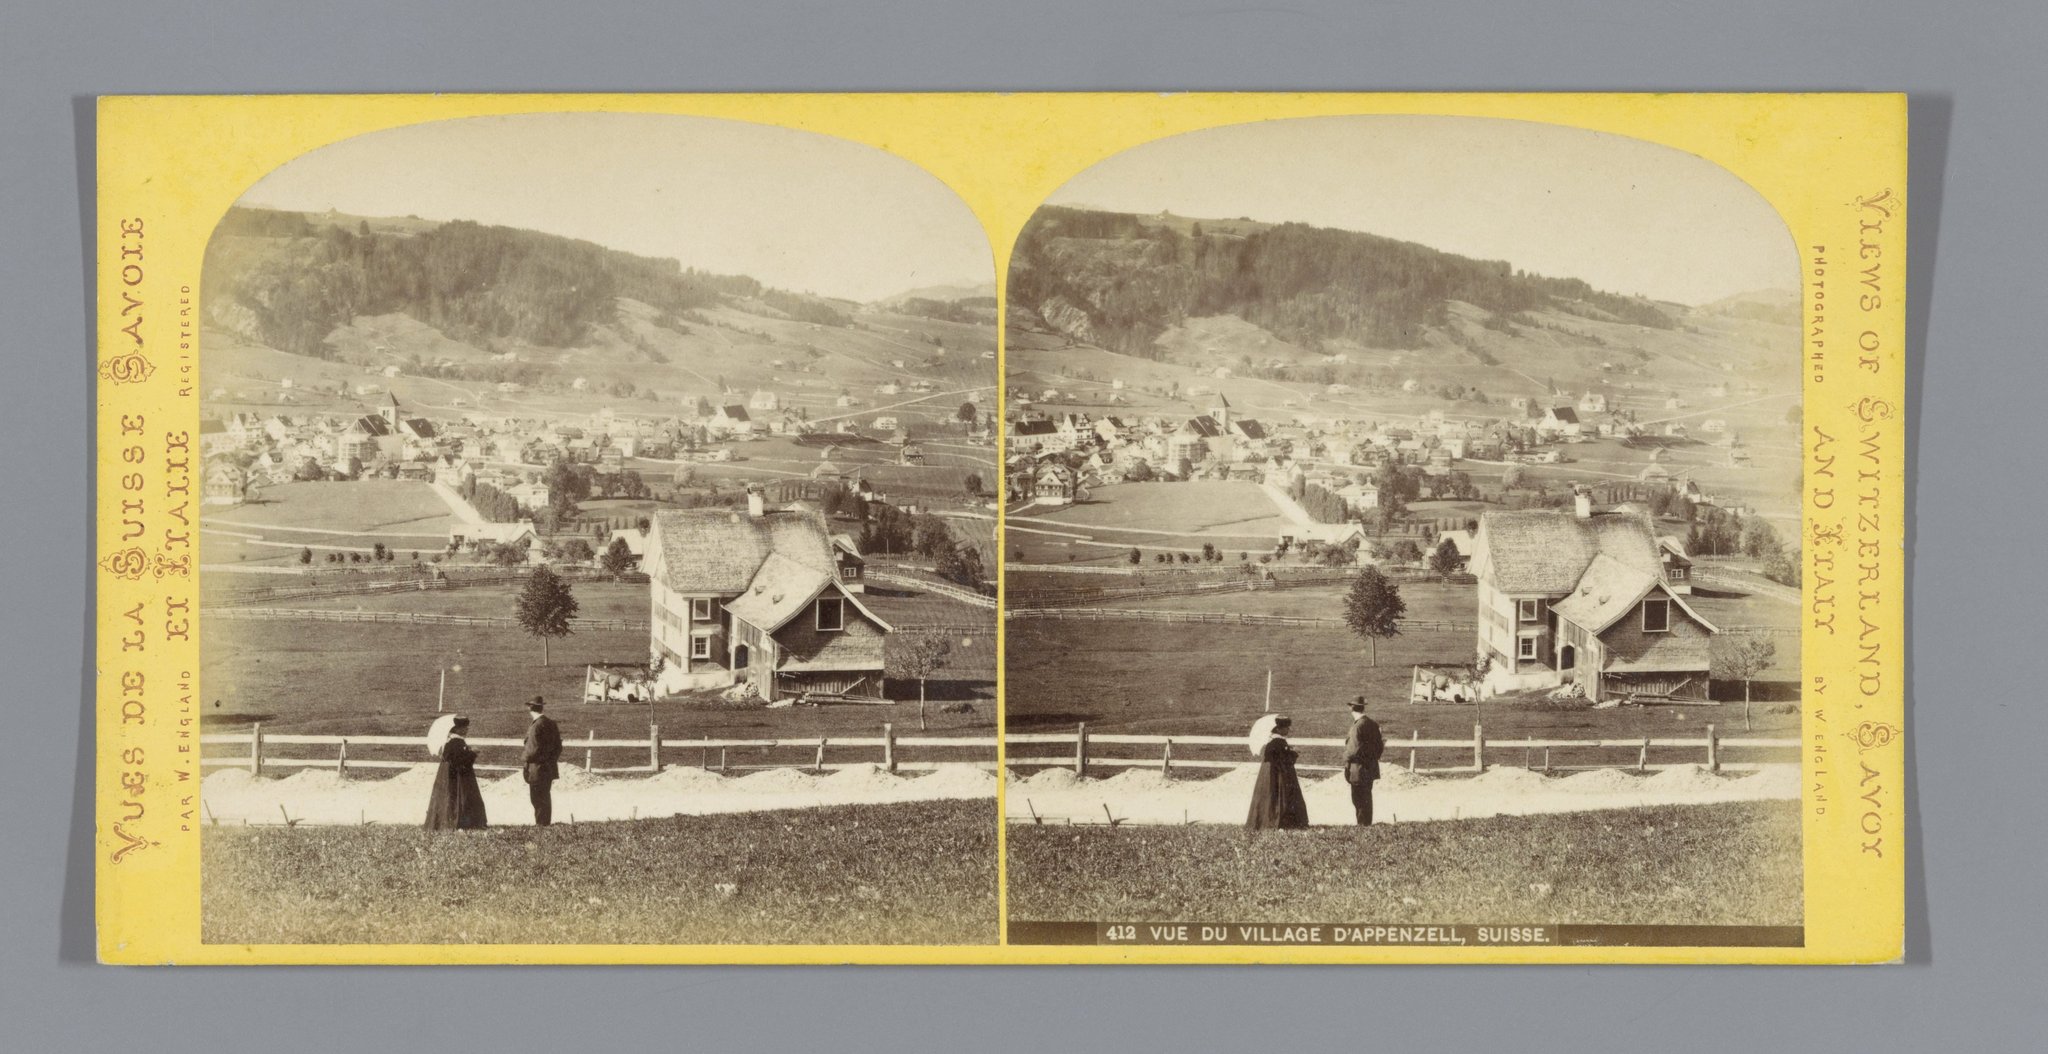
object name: stereograph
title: Gezicht op Appenzell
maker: william england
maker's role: fotograaf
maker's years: 1816-1896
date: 1850-1880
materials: cardboard, photographic support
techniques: albumen print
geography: appenzell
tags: prospect of city, town panorama, silhouette of city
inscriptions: inscription: ‘Vues de la Suisse Savoie et Italie’, number: ‘412’